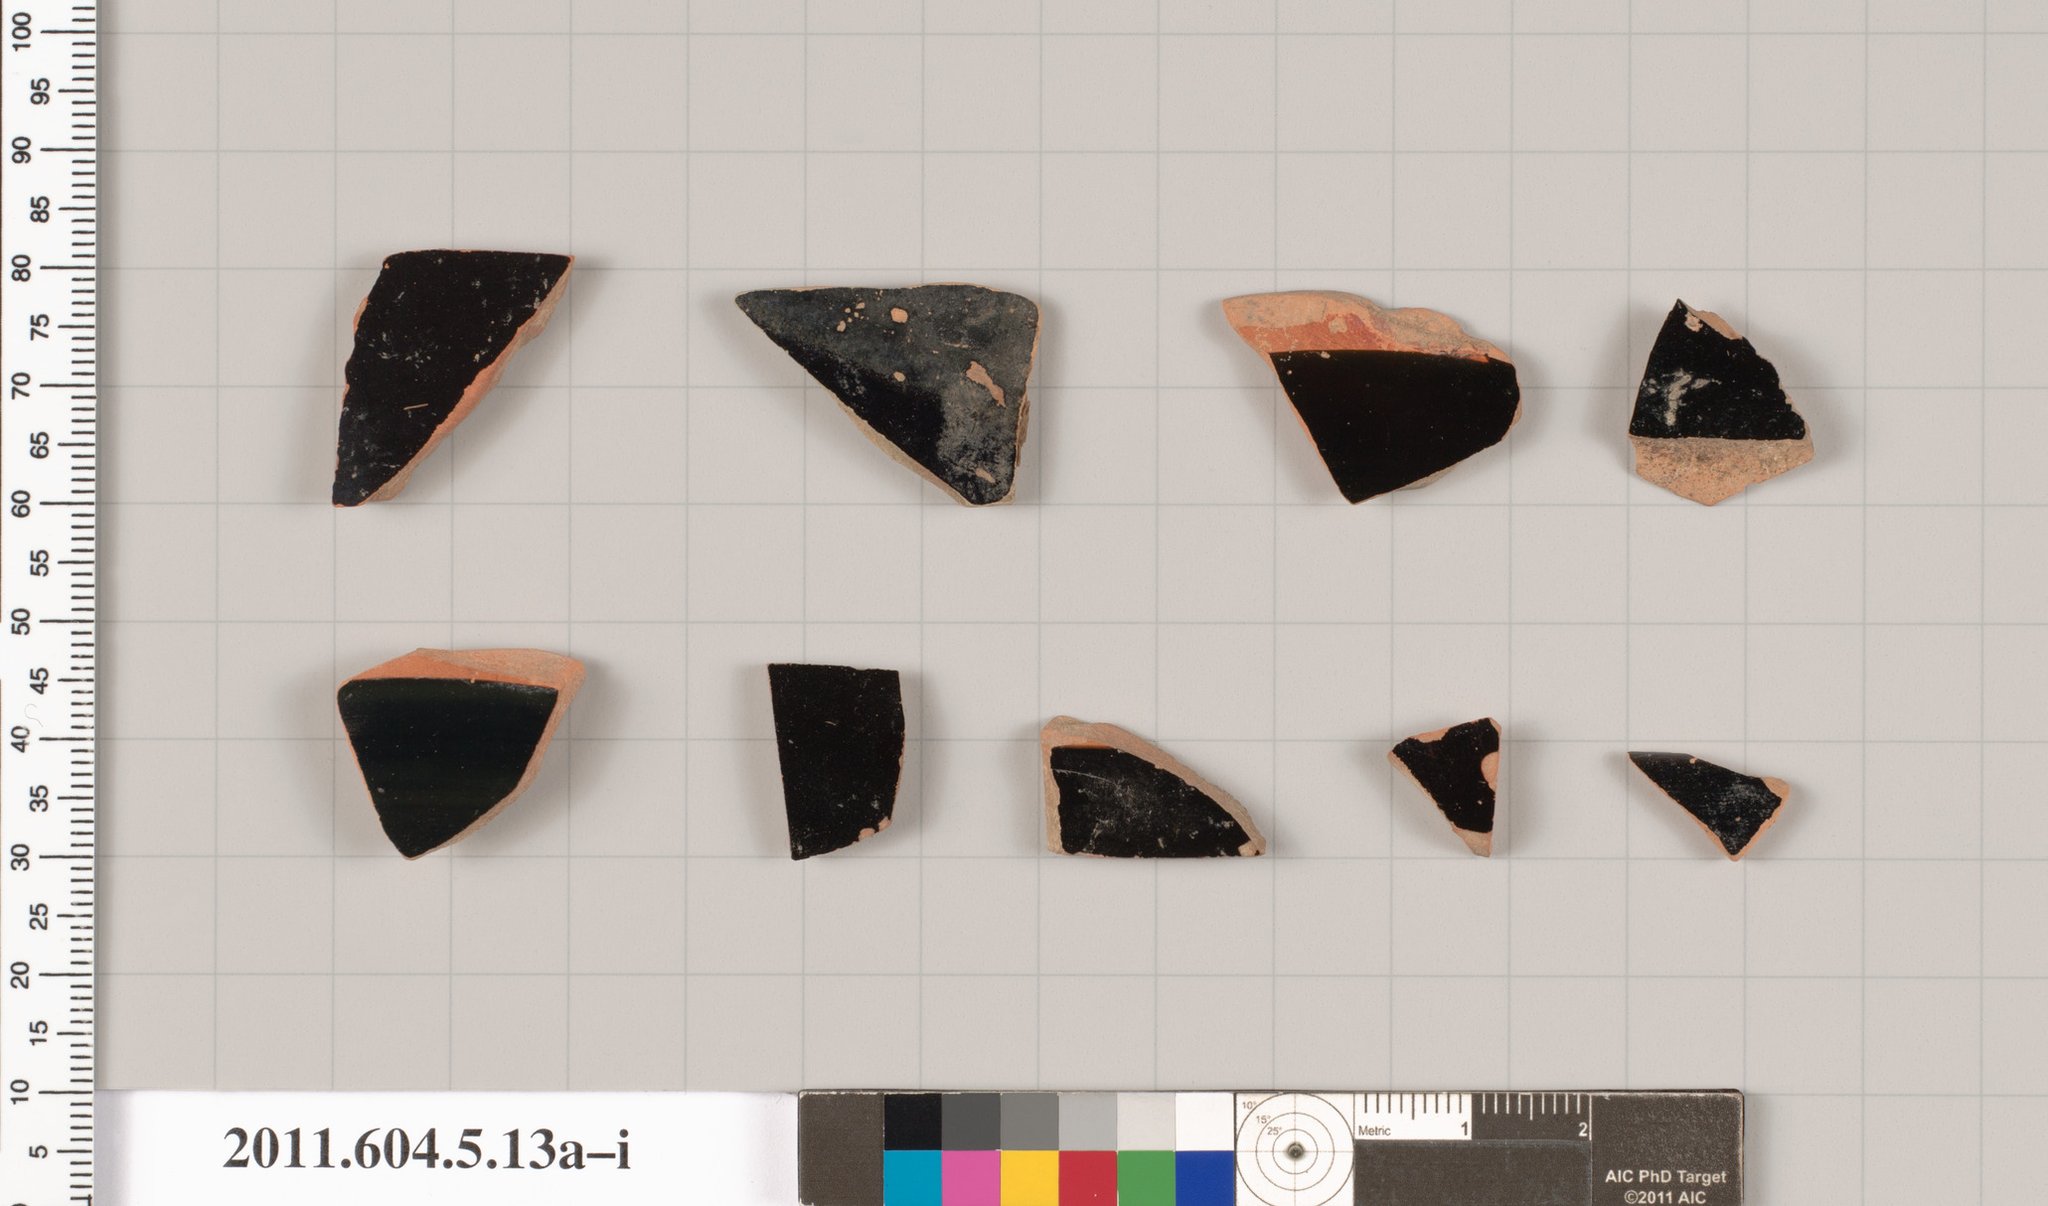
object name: kylix fragment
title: Terracotta fragments of kylikes (drinking cups)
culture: greek, attic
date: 475-451 BCE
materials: terracotta